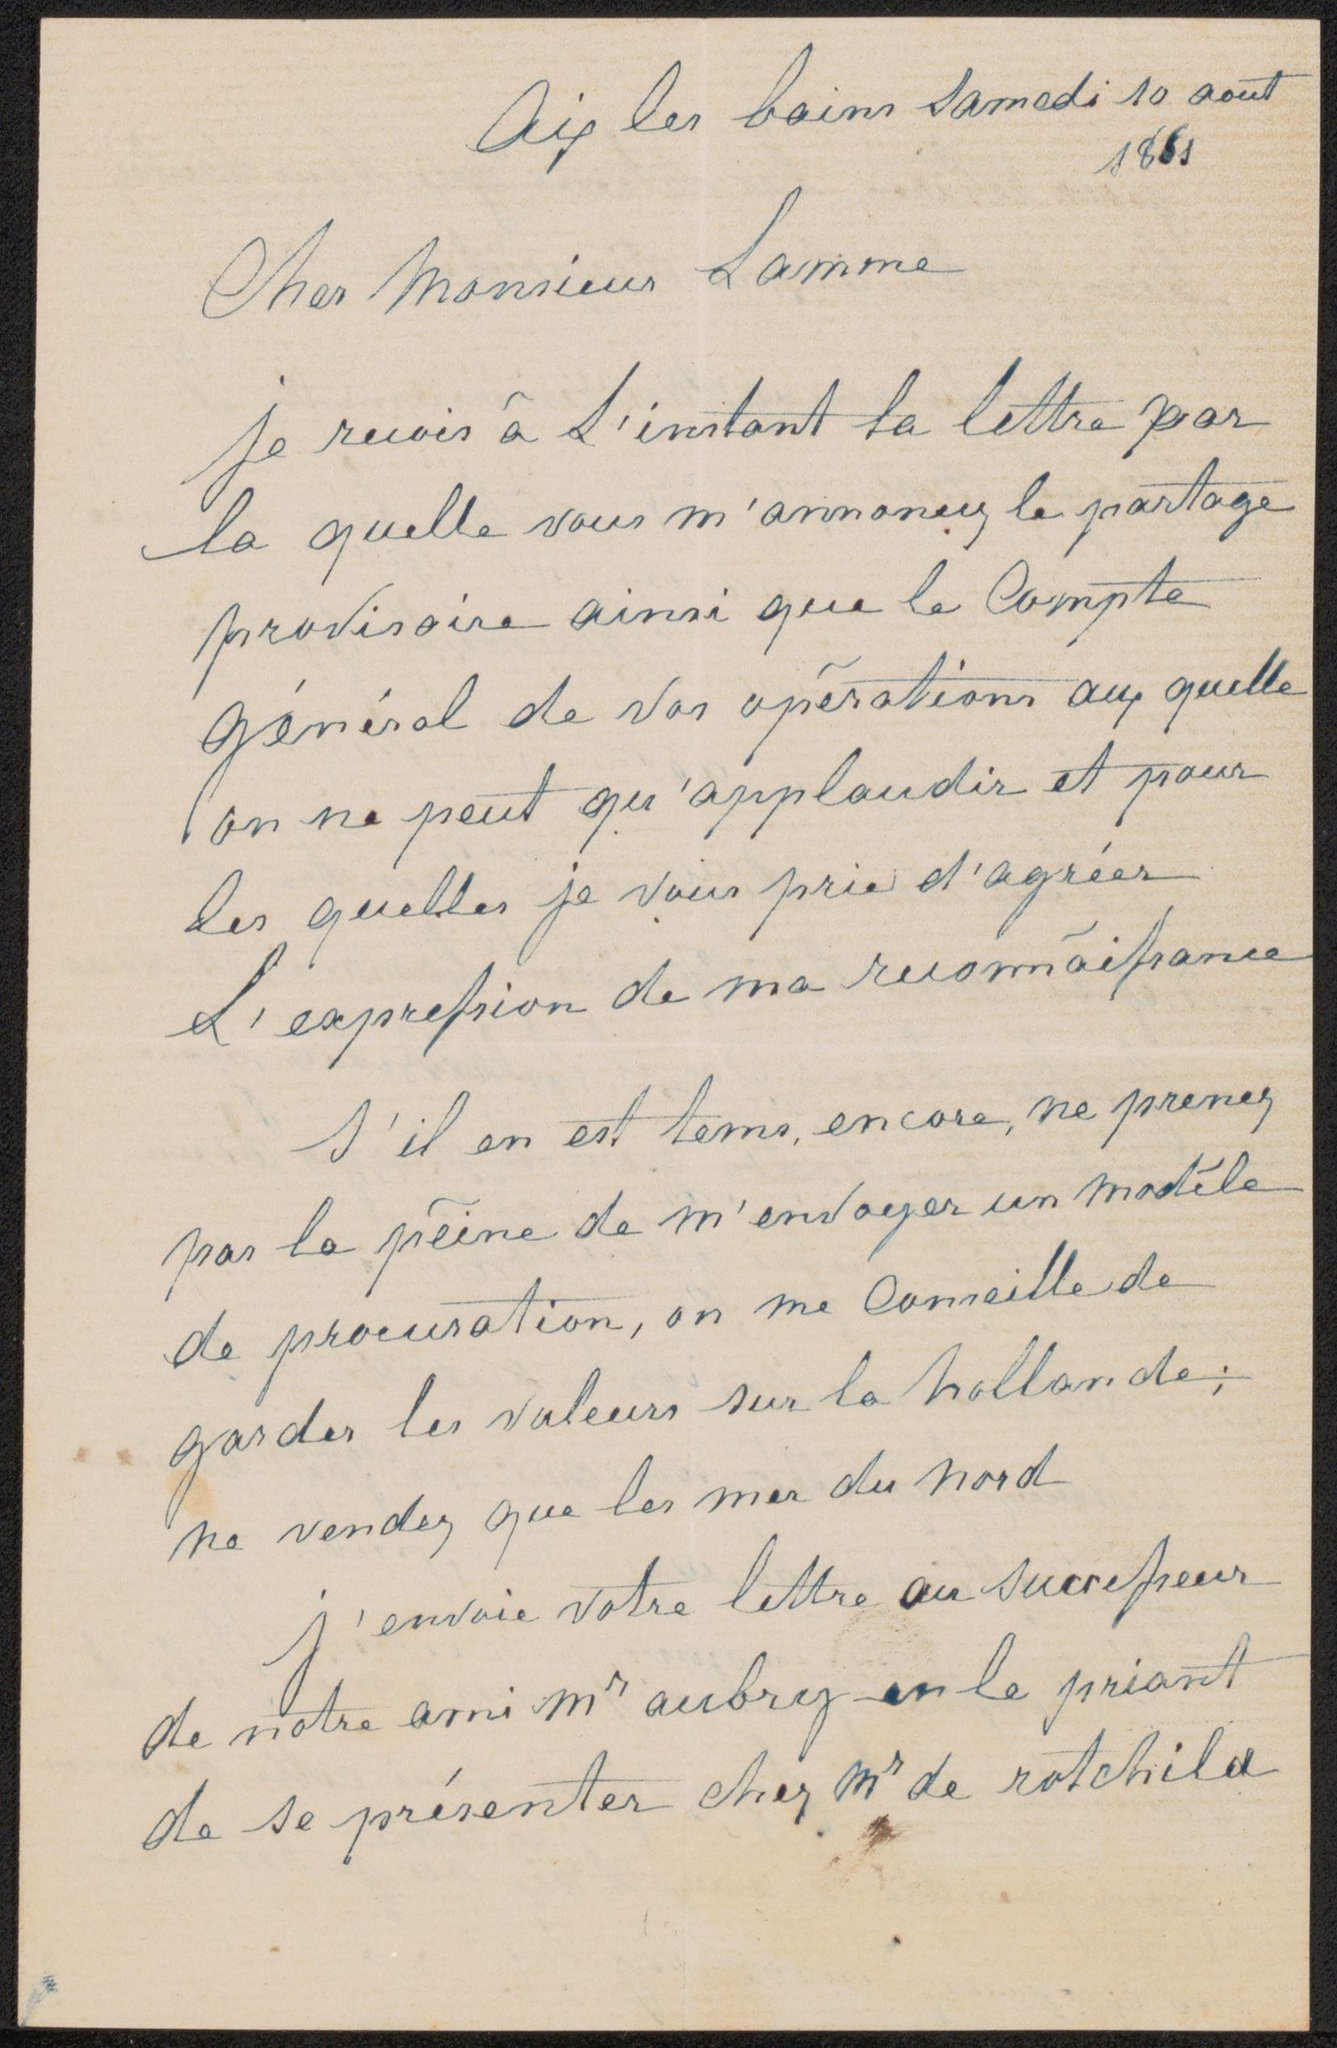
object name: letter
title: Brief aan Ary Johannes Lamme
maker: josephine fodor-mainville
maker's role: zangeres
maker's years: 1789-1870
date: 1861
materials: ink, paper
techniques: pen, writing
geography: aix-les-bains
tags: dordrecht, print maker, draughtsman, ary johannes lamme, amsterdam, carl joseph fodor, family life, money, lyon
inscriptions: collector's mark: Lugt 2228